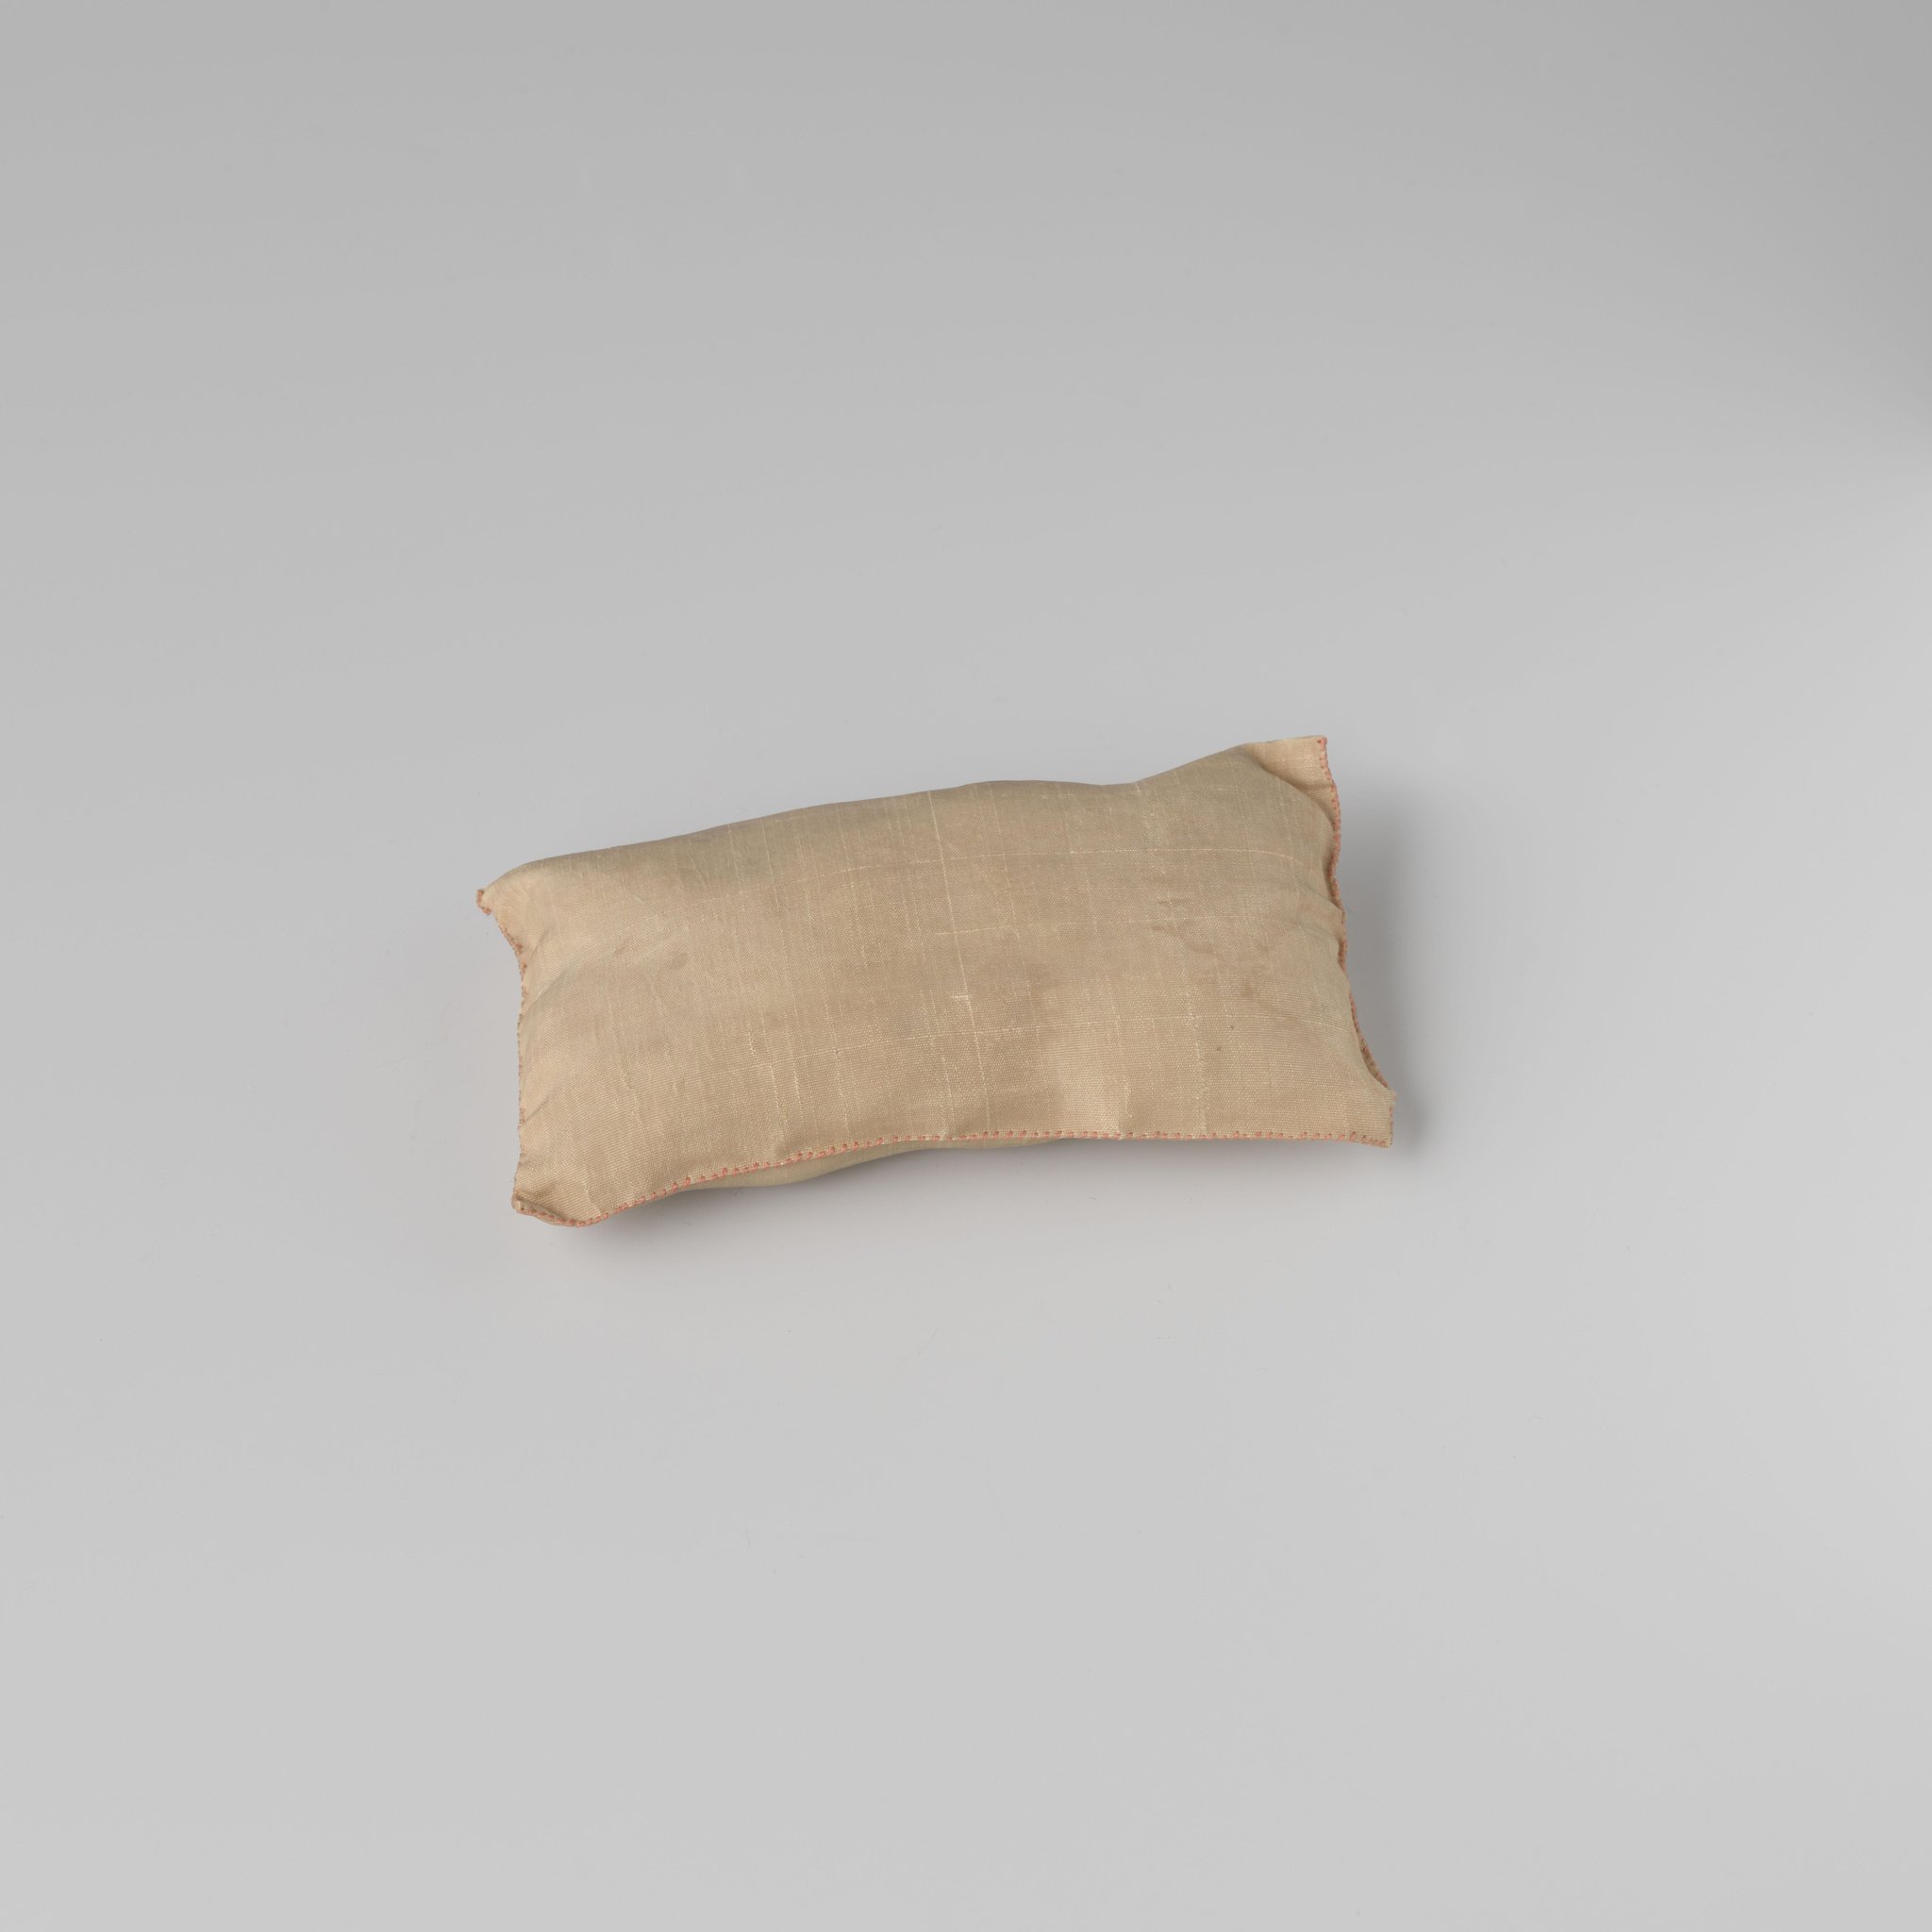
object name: bolster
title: Peluwkussen, vervaardigd van crèmekleurige zijde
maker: Anonymous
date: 1676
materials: cotton, silk, wool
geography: amsterdam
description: Peluwkussen van crèmekleurige zijde. De naden zijn vastgezet met roze draad (rolzoom). Het matras is gevuld met wolpluis of katoenpluis.